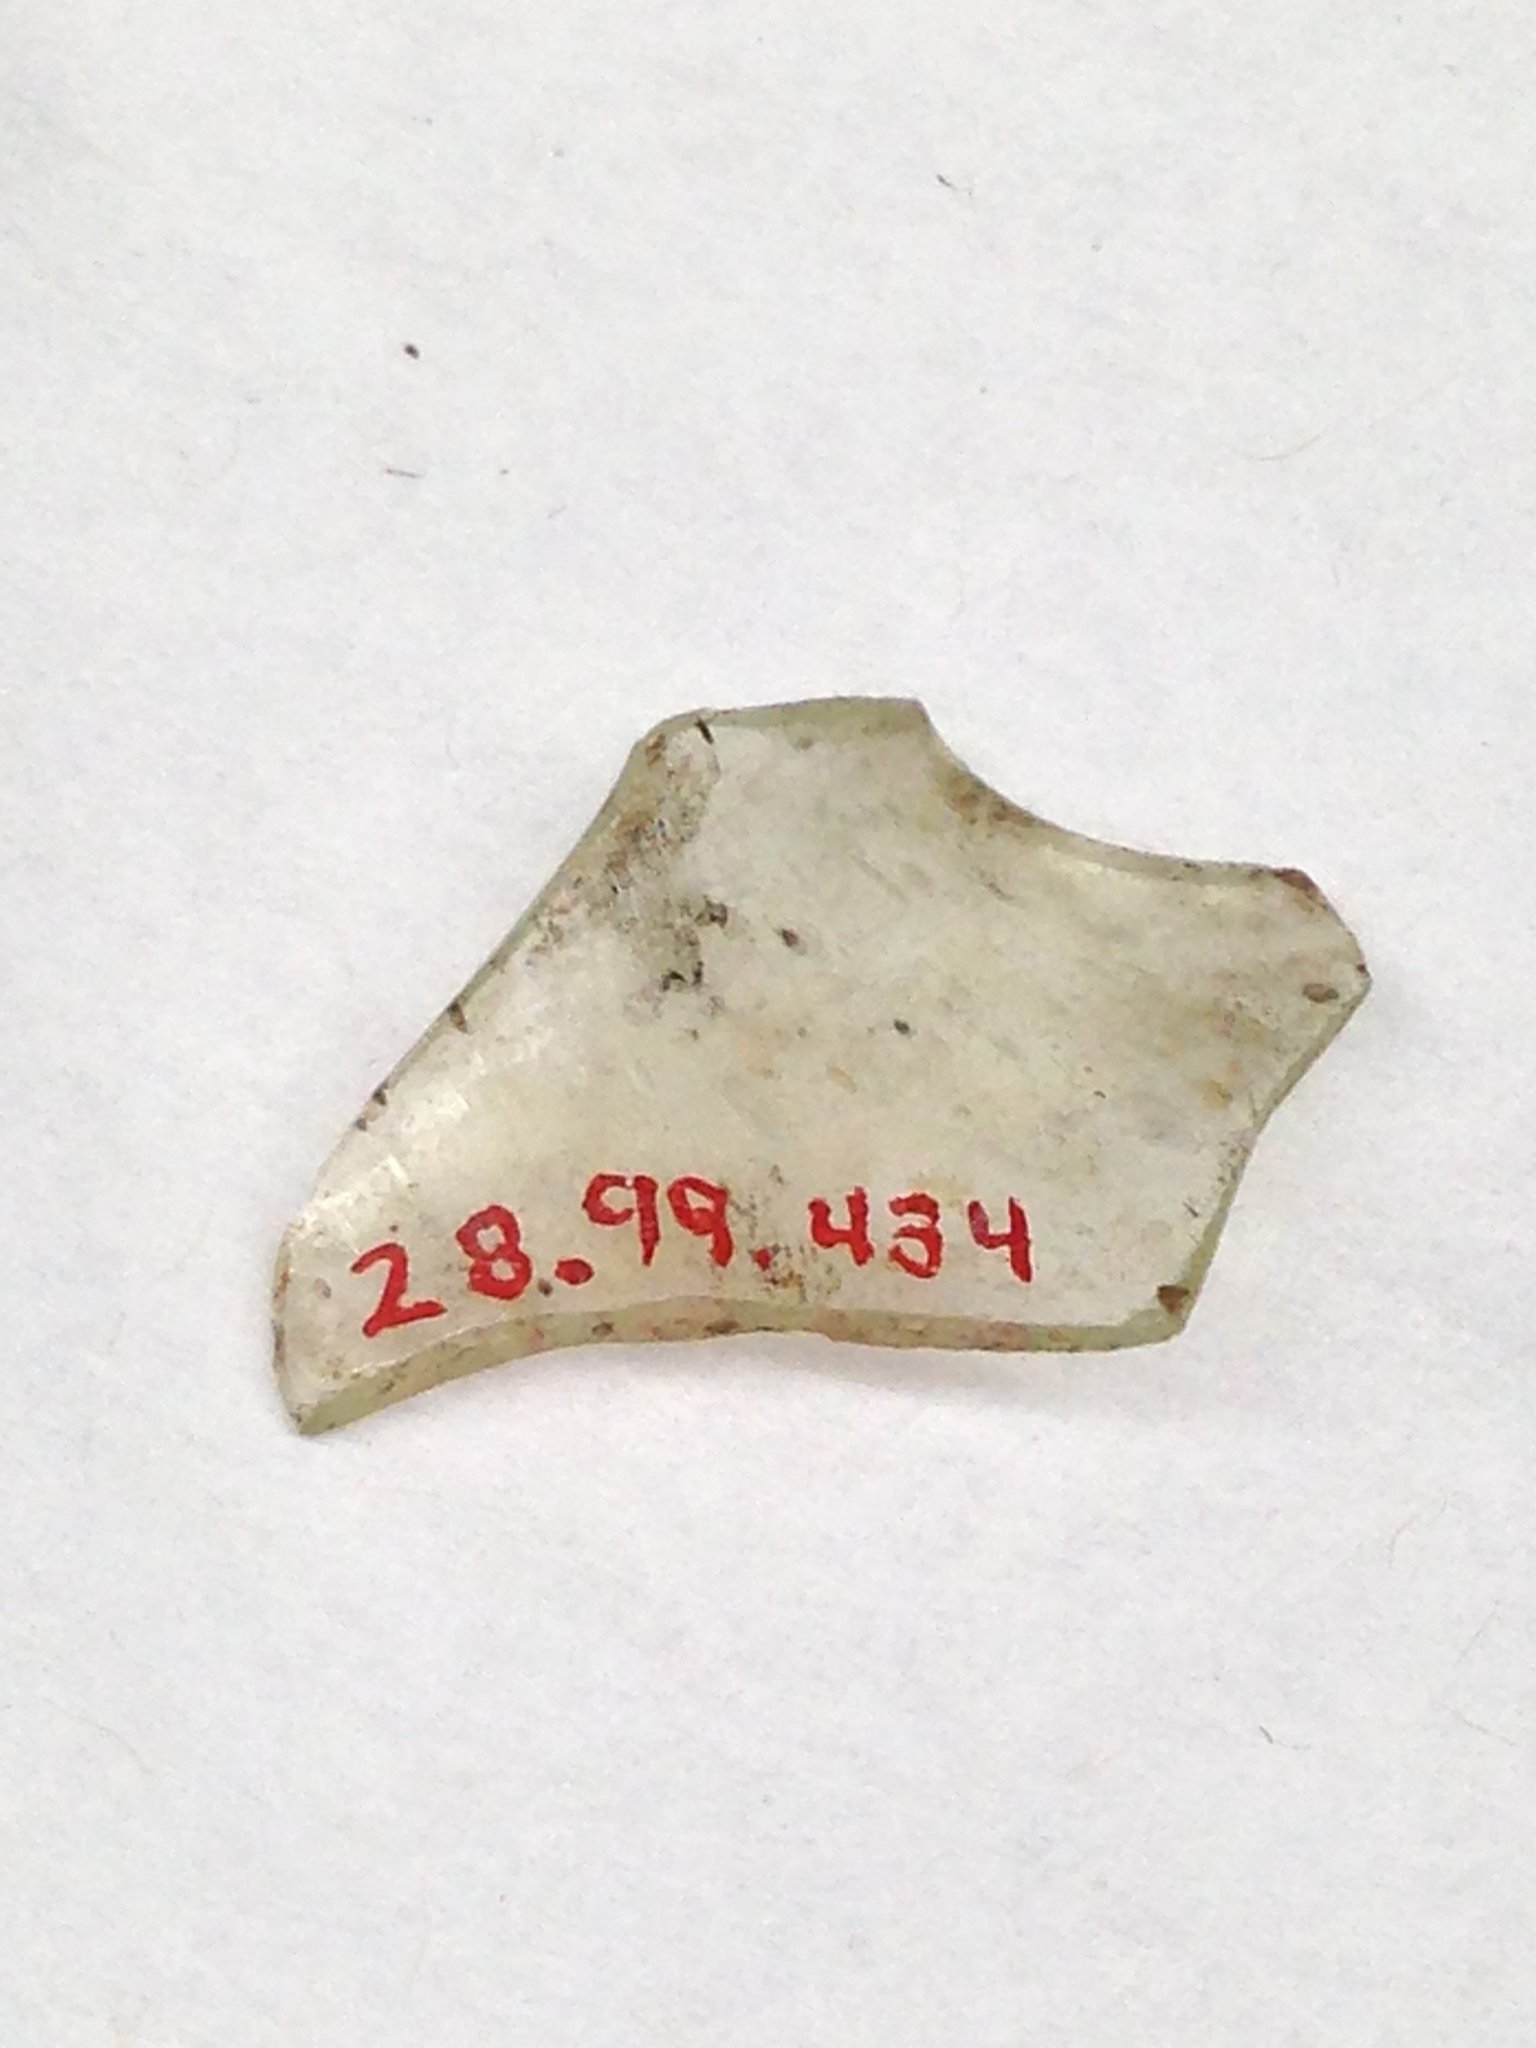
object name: fragment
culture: european or middle eastern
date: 1150-1250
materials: ceramic, glass